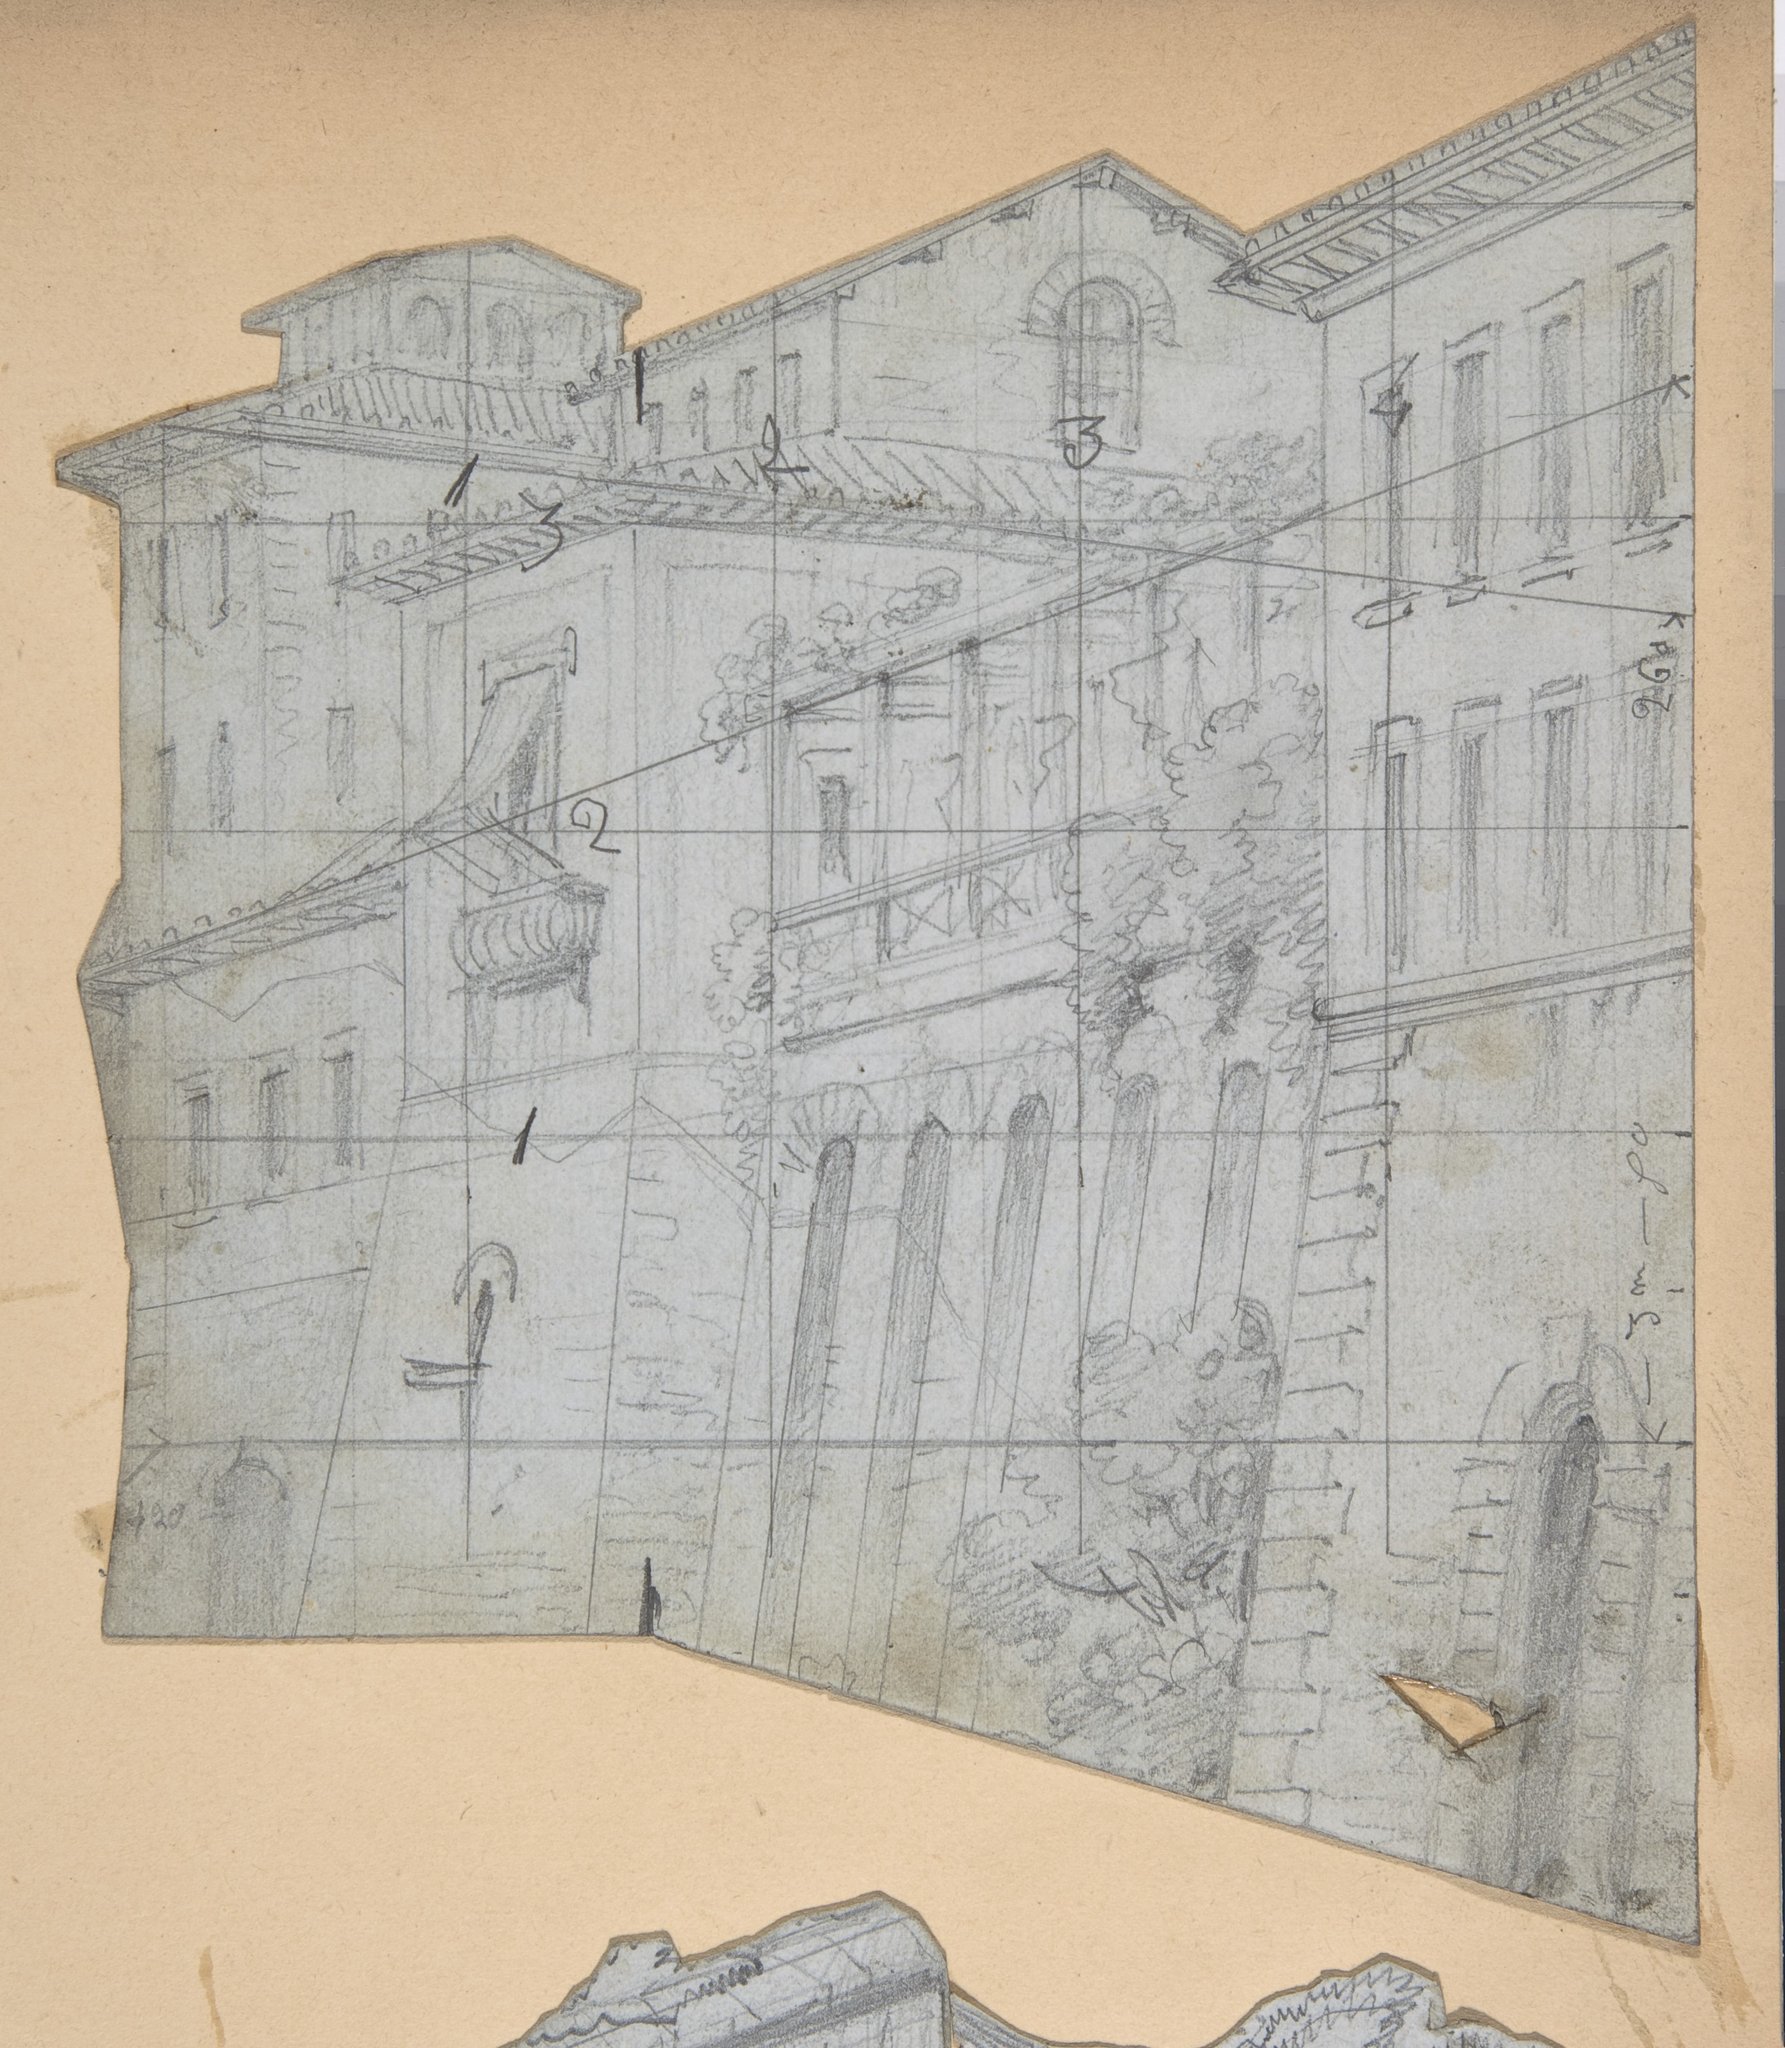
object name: drawing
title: Design for a Stage Set at the Opéra, Paris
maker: eugène cicéri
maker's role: artist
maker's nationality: french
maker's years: 1813-1890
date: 1830-1890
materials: graphite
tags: buildings,stage design